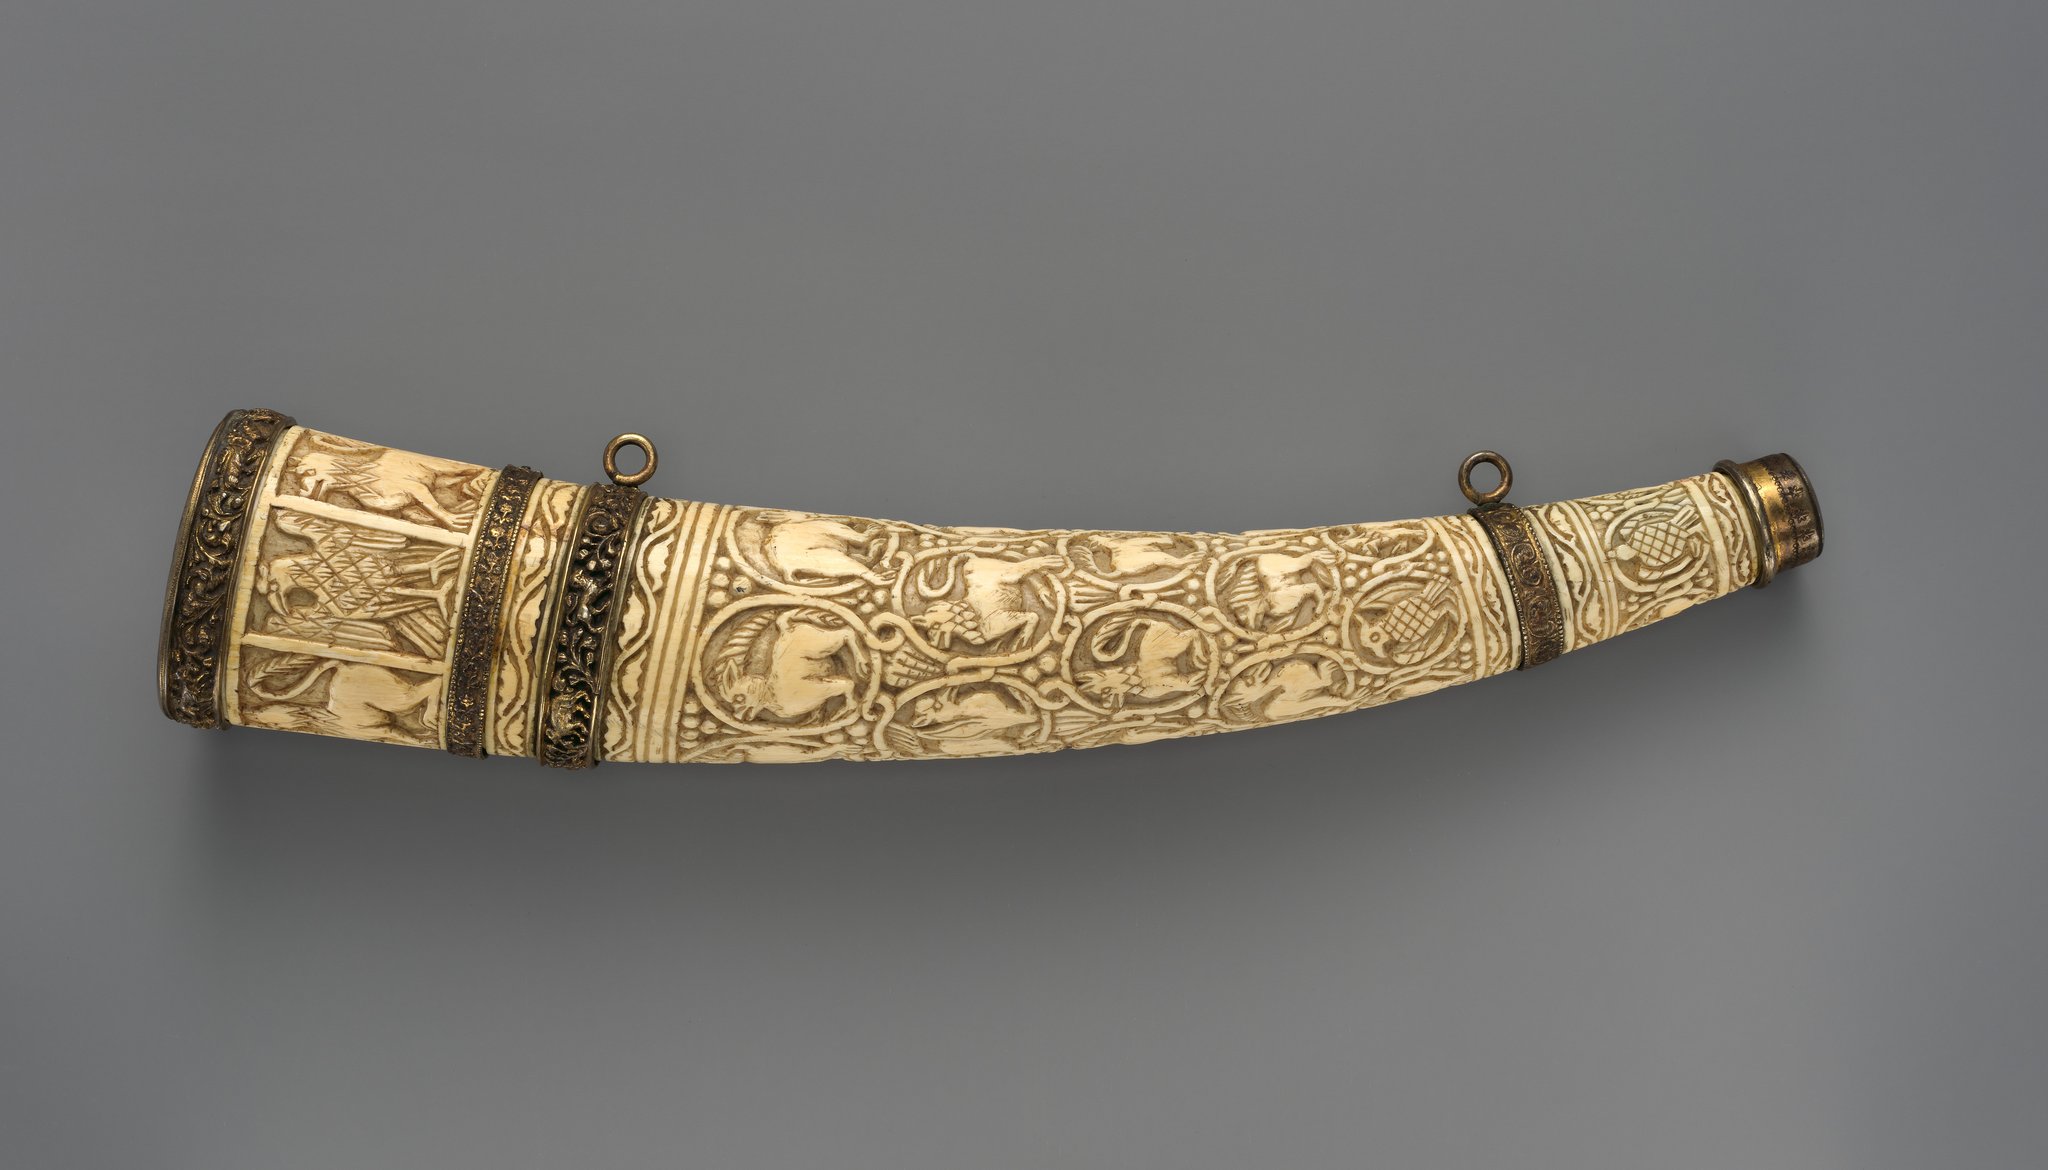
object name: oliphant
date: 1101-1300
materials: bronze, gilt silver, ivory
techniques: carving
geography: italy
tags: horns,mythical creatures